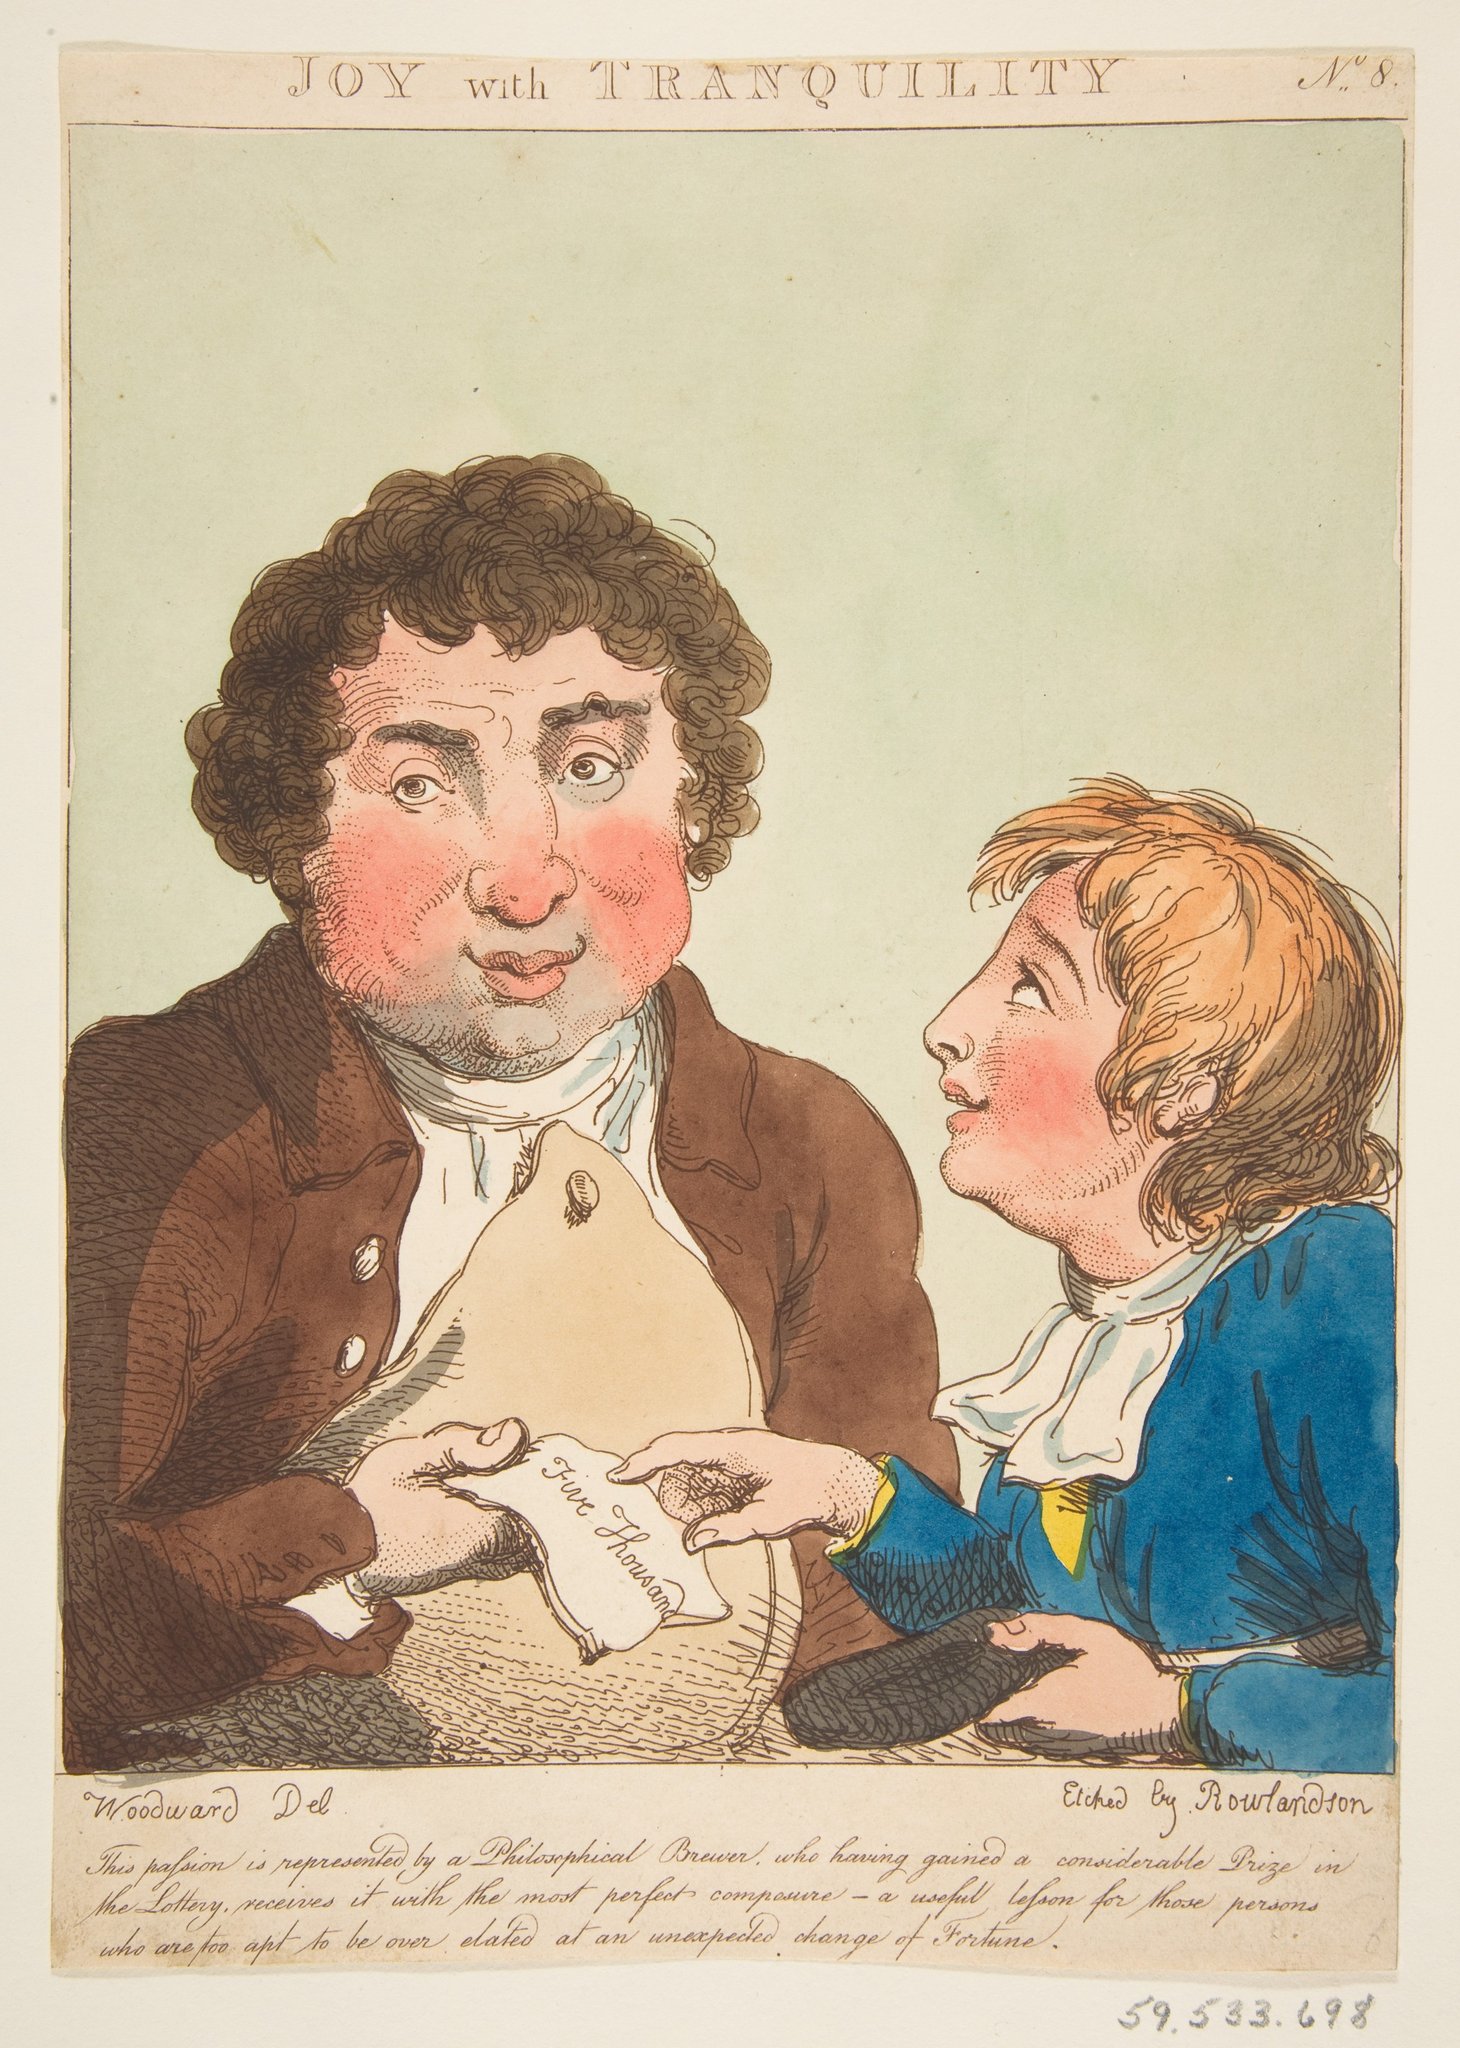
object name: print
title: Joy with Tranquility (Le Brun Travested, or Caricatures of the Passions)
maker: thomas rowlandson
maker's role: artist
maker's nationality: british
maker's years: 1757-1827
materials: ink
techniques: etching, printing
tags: satire,men